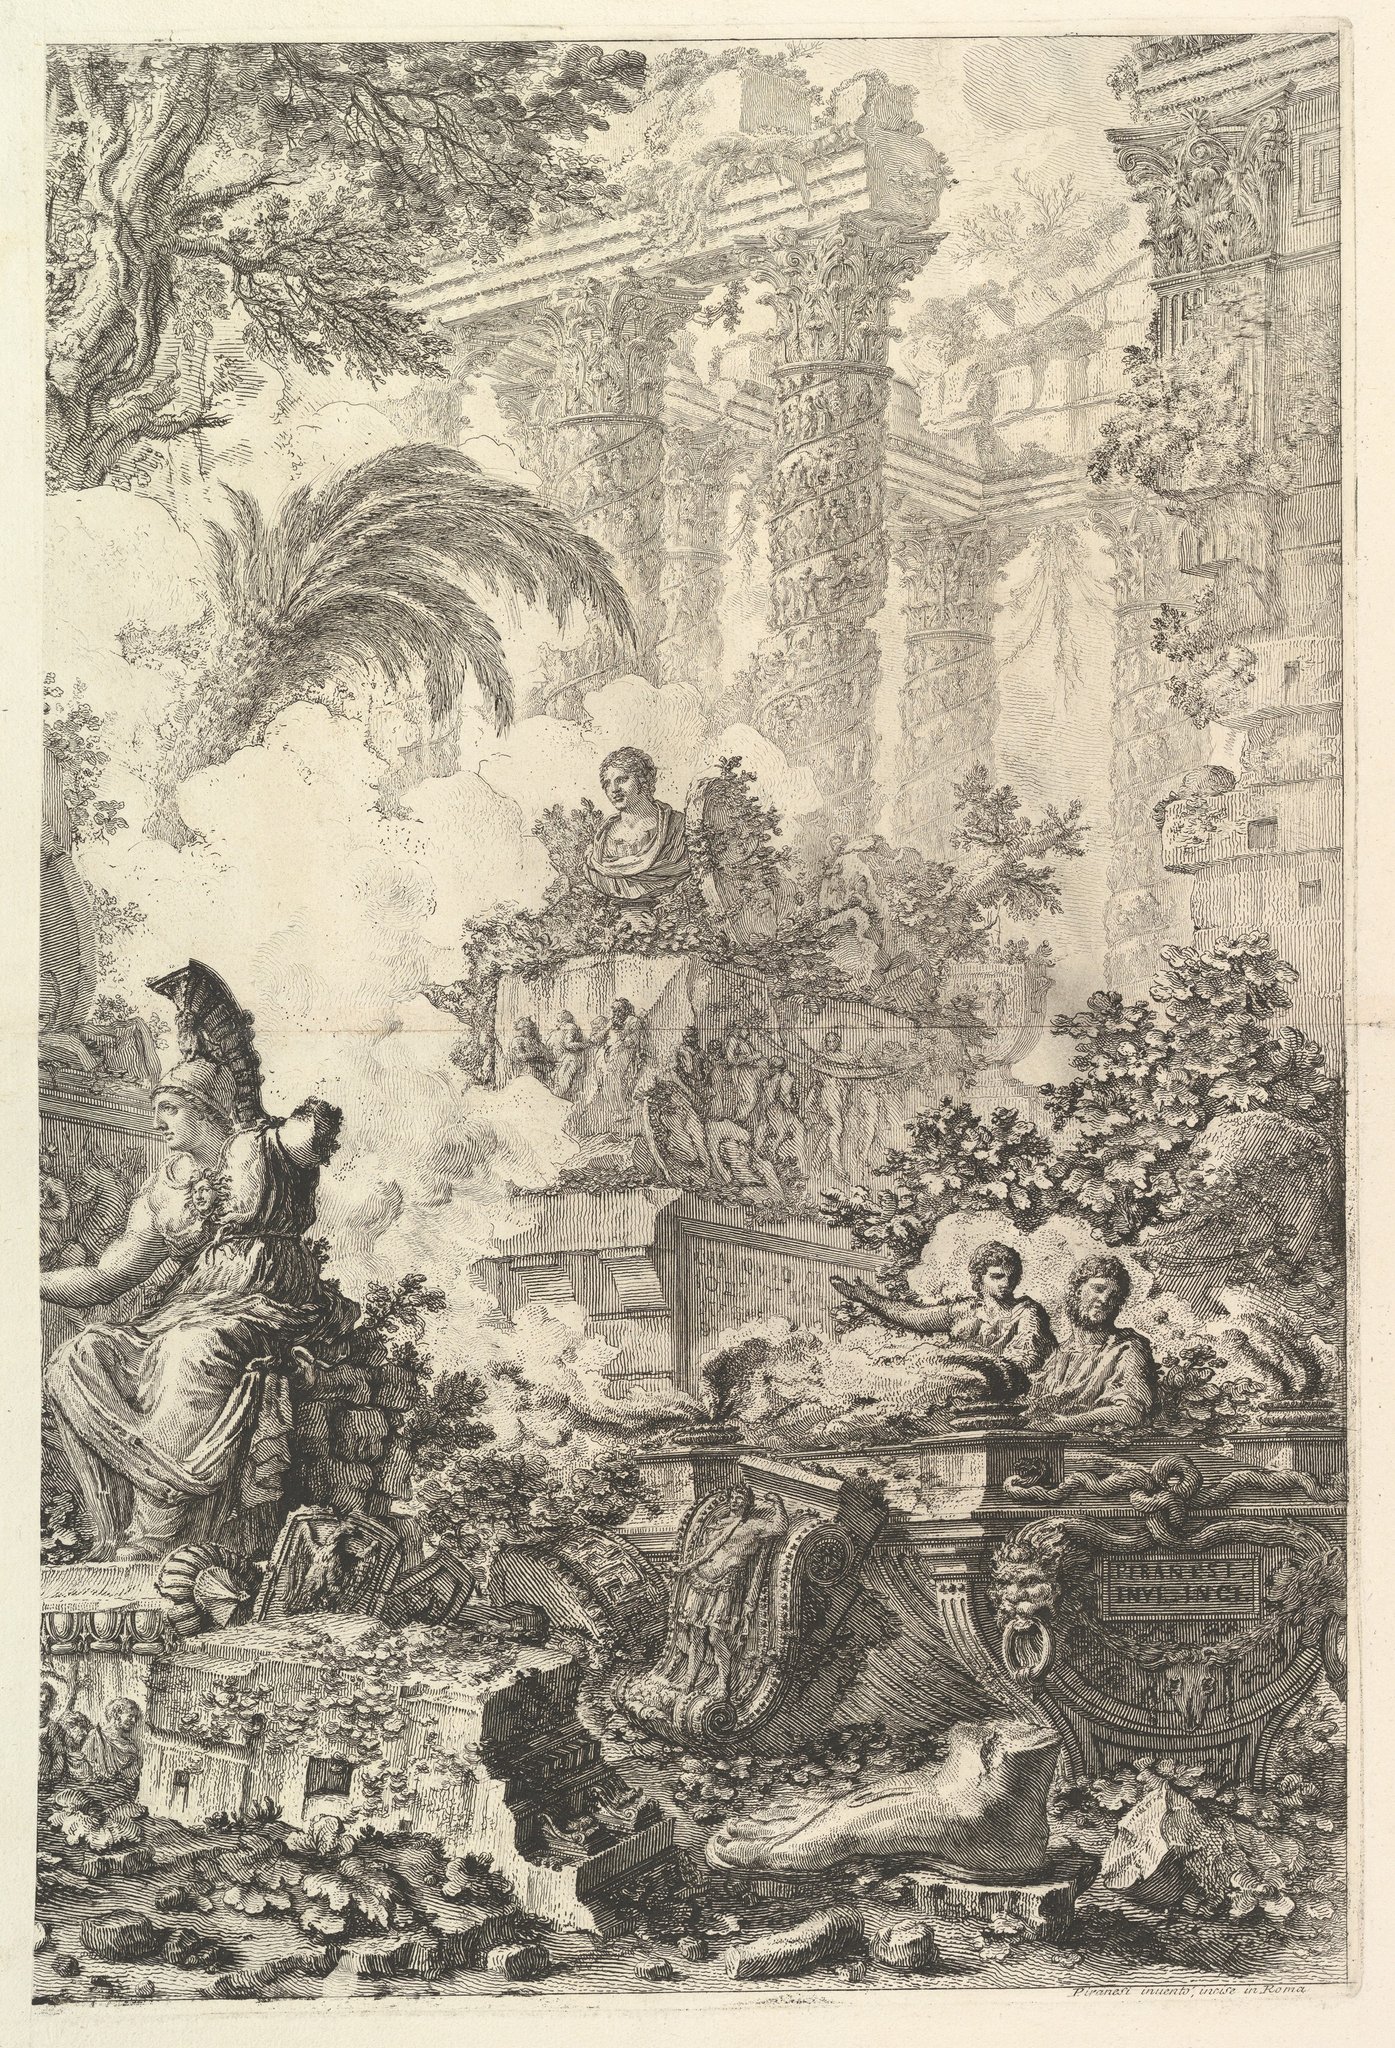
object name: print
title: Frontispiece, with Statue of Minerva, from "Vedute di Roma"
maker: giovanni battista piranesi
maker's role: artist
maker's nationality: italian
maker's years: 1720-1778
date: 1748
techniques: etching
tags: ruins,minerva